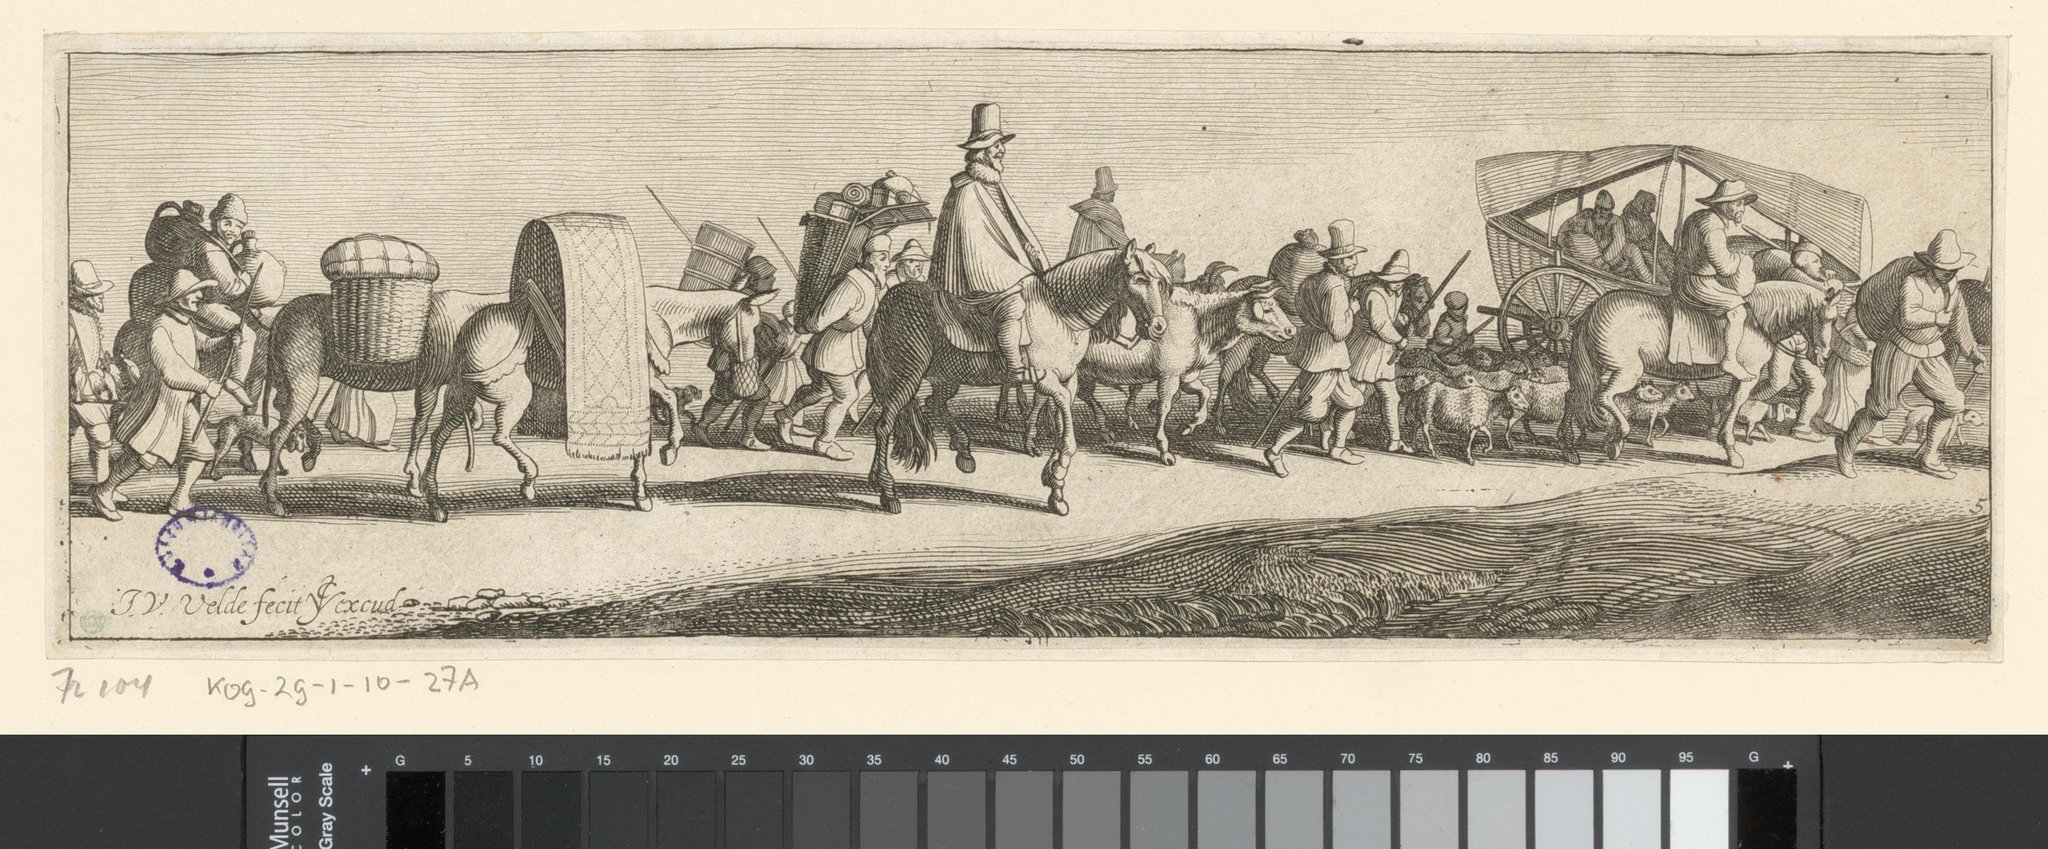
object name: print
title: Stoet van marktkooplui en marktgangers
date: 1603-1652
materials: paper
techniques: engraving, etching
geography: amsterdam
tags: going to the market, market, (farm) wagon, freight wagon, cart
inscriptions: collector's mark: Lugt 5100, collector's mark: Lugt 1641, collector's mark: Lugt 1934, stamp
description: Een stoet van marktkooplui, naar rechts. Vooraan een huifkar, waarnaast een kudde schapen. Daarachter een koe, mensen met manden op hun rug, een bepakte ezel en enkele mensen te paard. Eerste prent van een fries bestaande uit vier prenten, voorstellende een markt. Vijfde prent uit de totale serie markten (serie markt A + B). Rechts genummerd: 5. Onderwerpsrubrieken binnen de Atlas Zeden en Gewoonten: Handel, nijverheid en verkeer, Marktwezen, Markttafereelen, Marktfiguren.